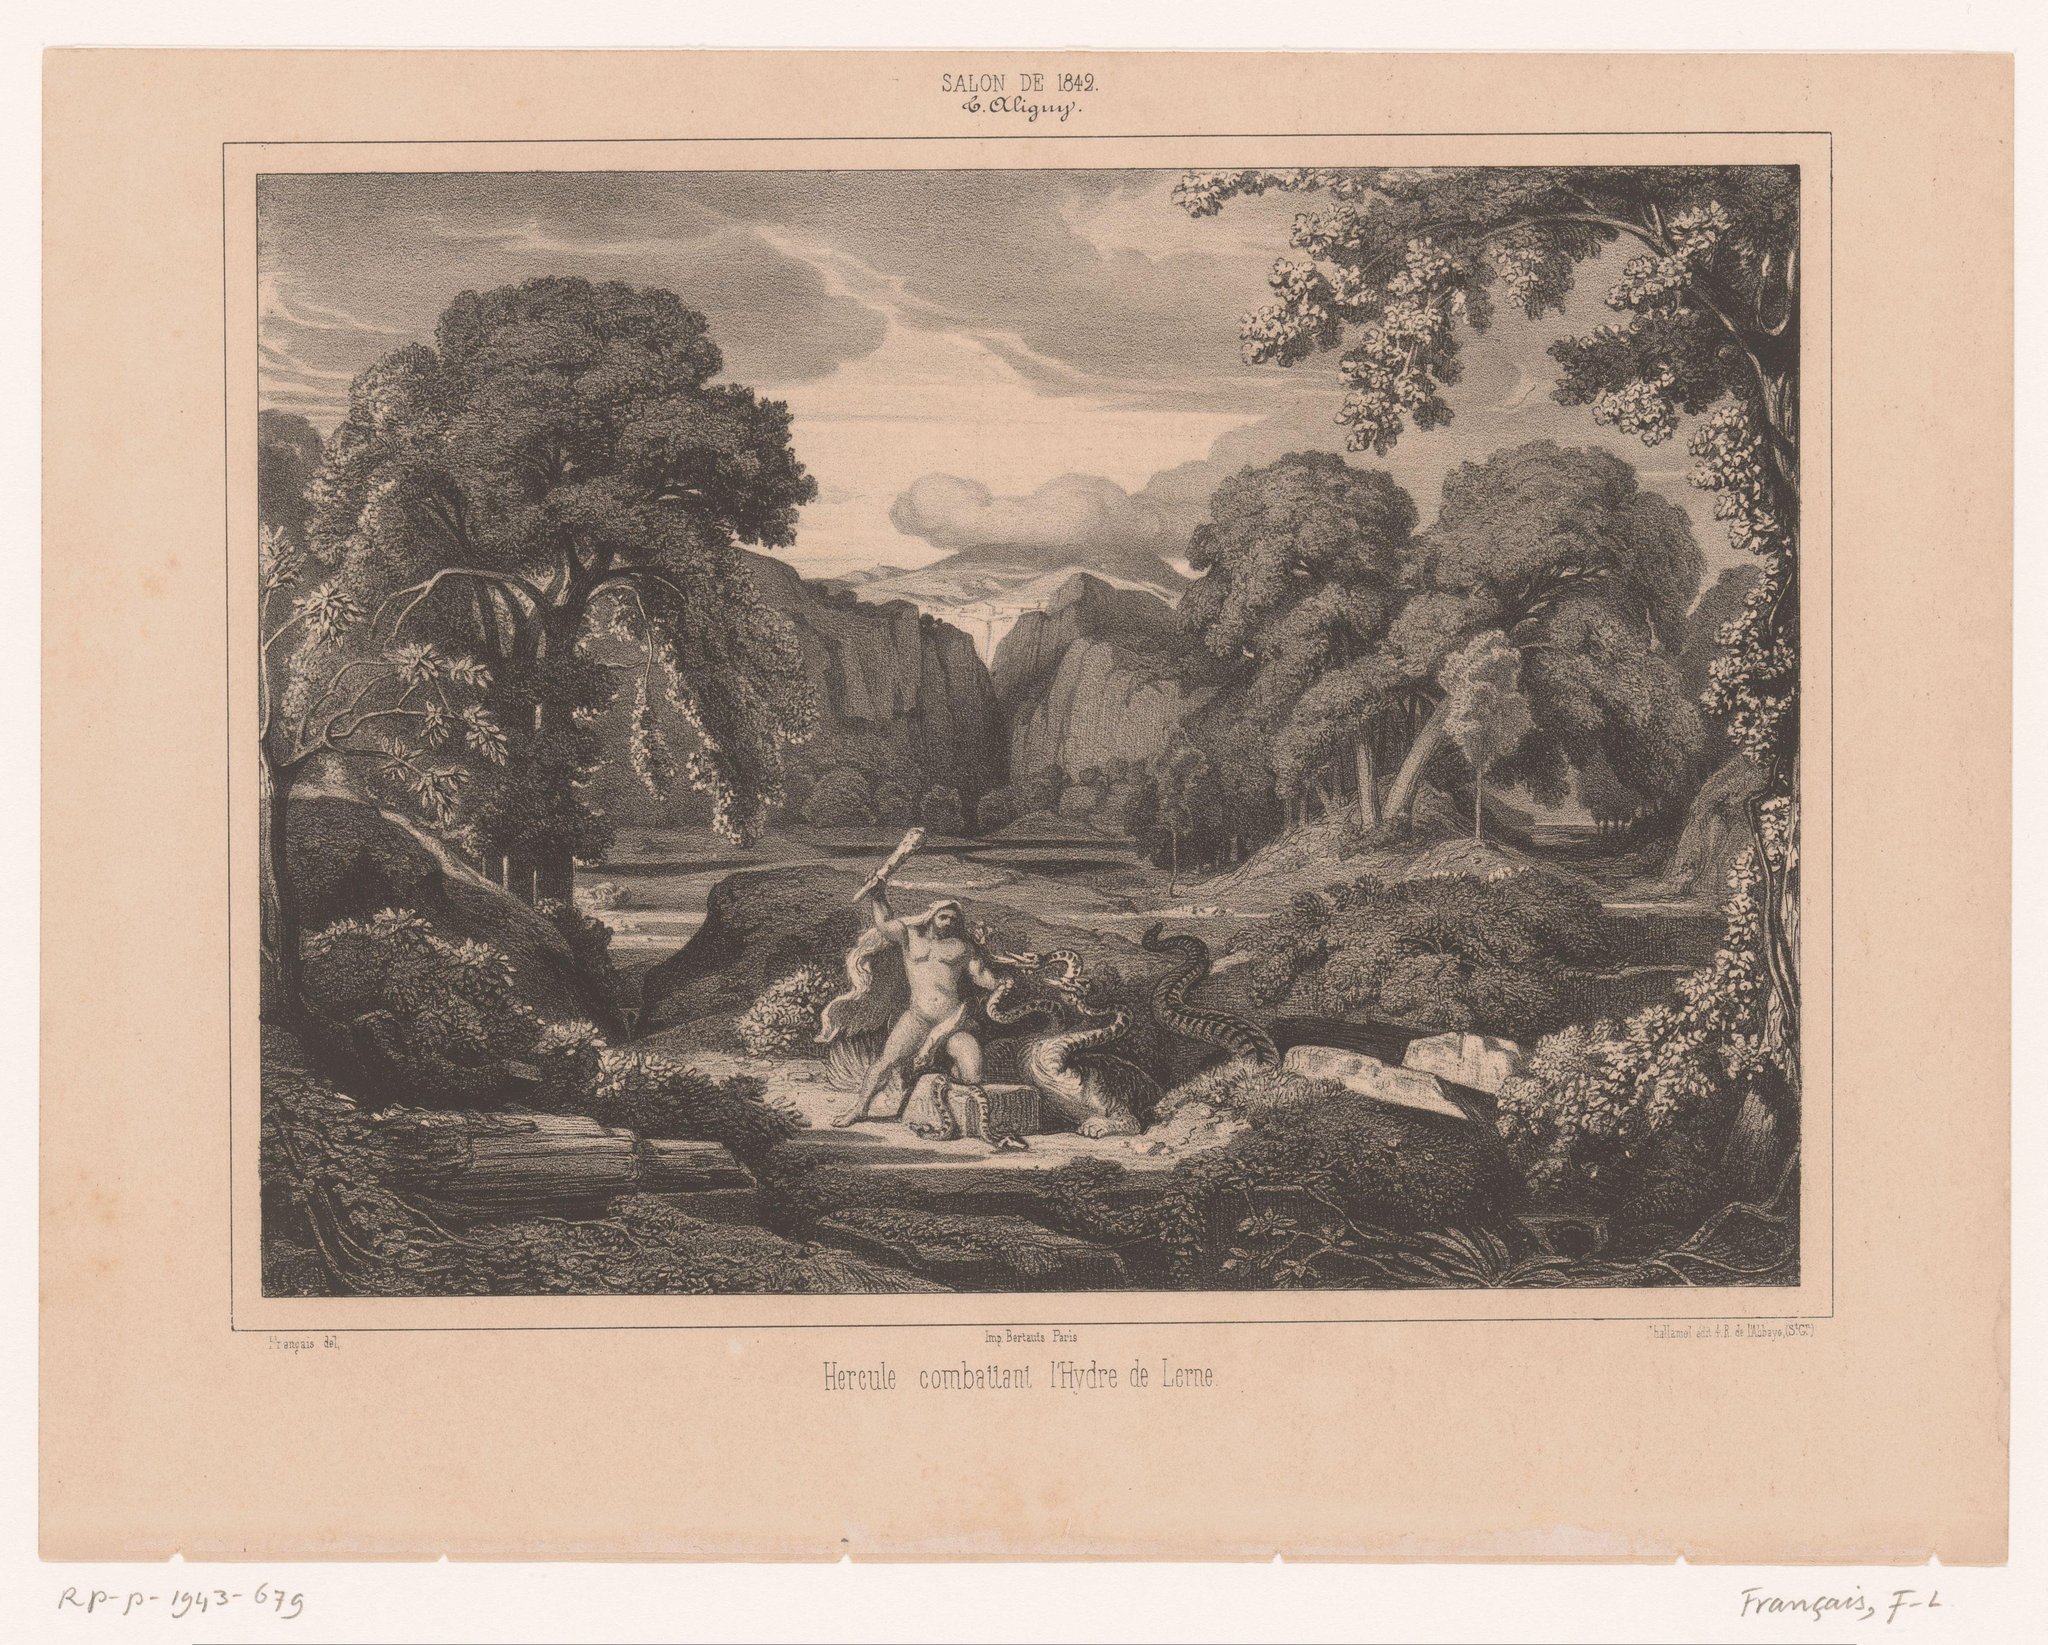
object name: print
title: Hercules doodt de Hydra van Lerna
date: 1842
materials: paper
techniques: lithograph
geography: paris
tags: (2) the hydra of lerna is killed by hercules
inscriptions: collector's mark: Lugt 2228a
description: Prent gebruikt in: Ténint, Wilhelm. Album du Salon de 1842. Collection des principaux ouvrages exposés au Louvre (…). Parijs: Augustin Challamel, 1842.